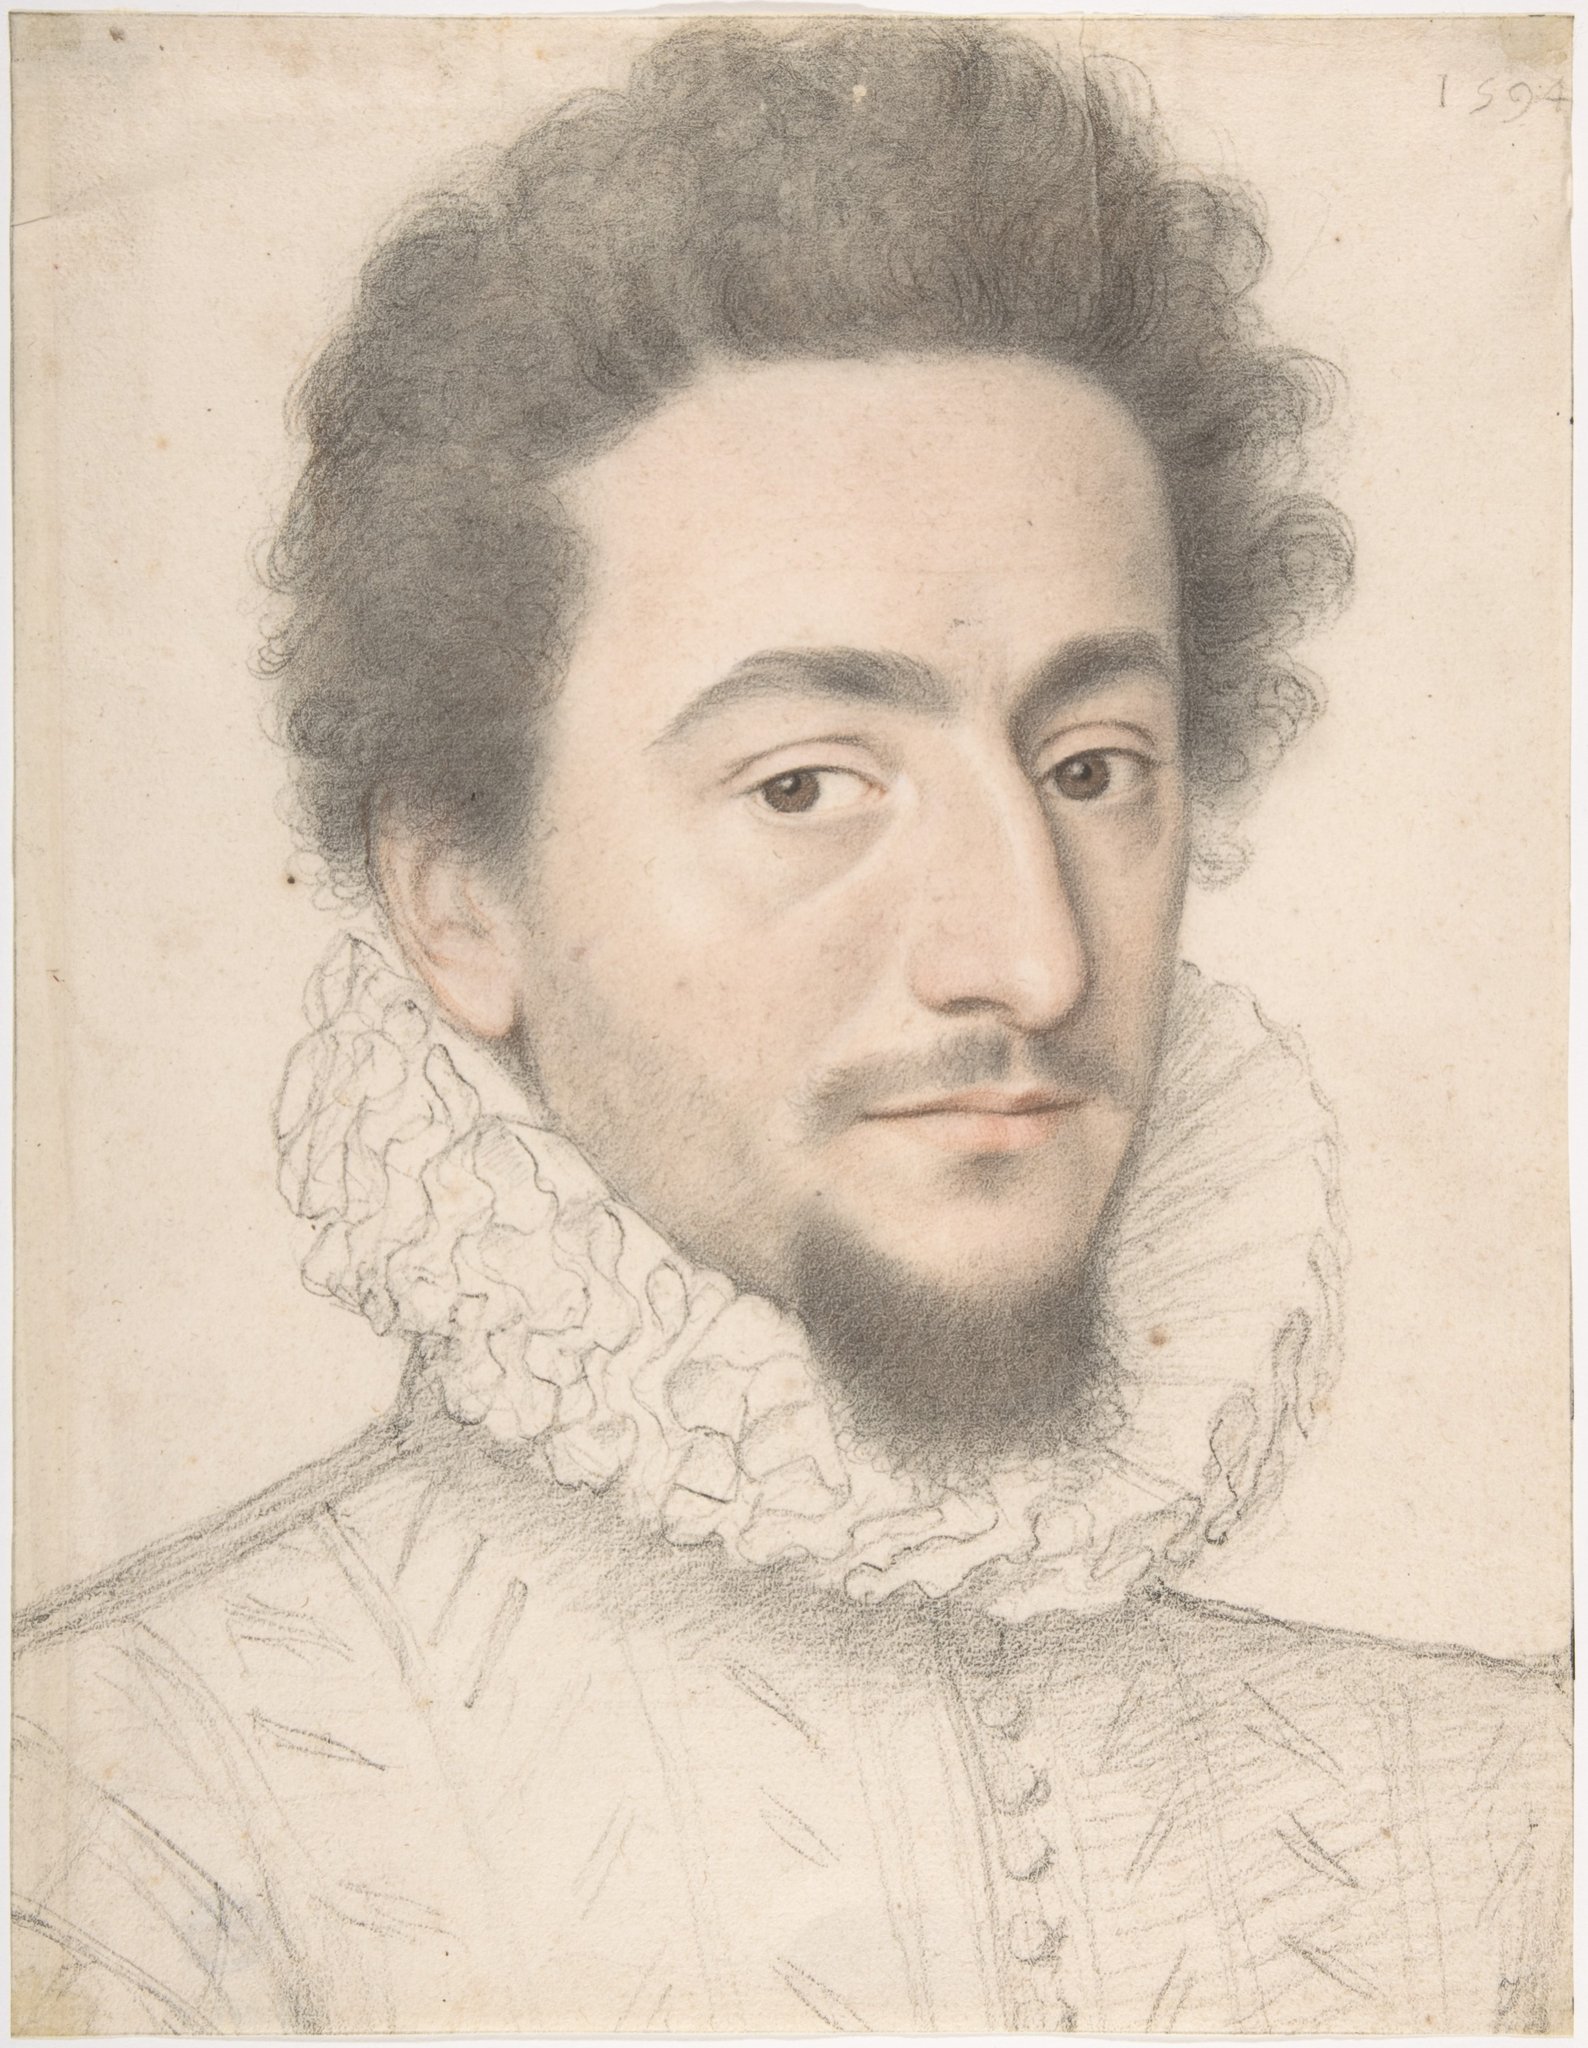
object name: drawing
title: Portrait of a Man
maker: anonymous, french, 16th century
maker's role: artist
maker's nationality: french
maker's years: 1500-1600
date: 1594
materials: chalk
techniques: heightening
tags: men,portraits